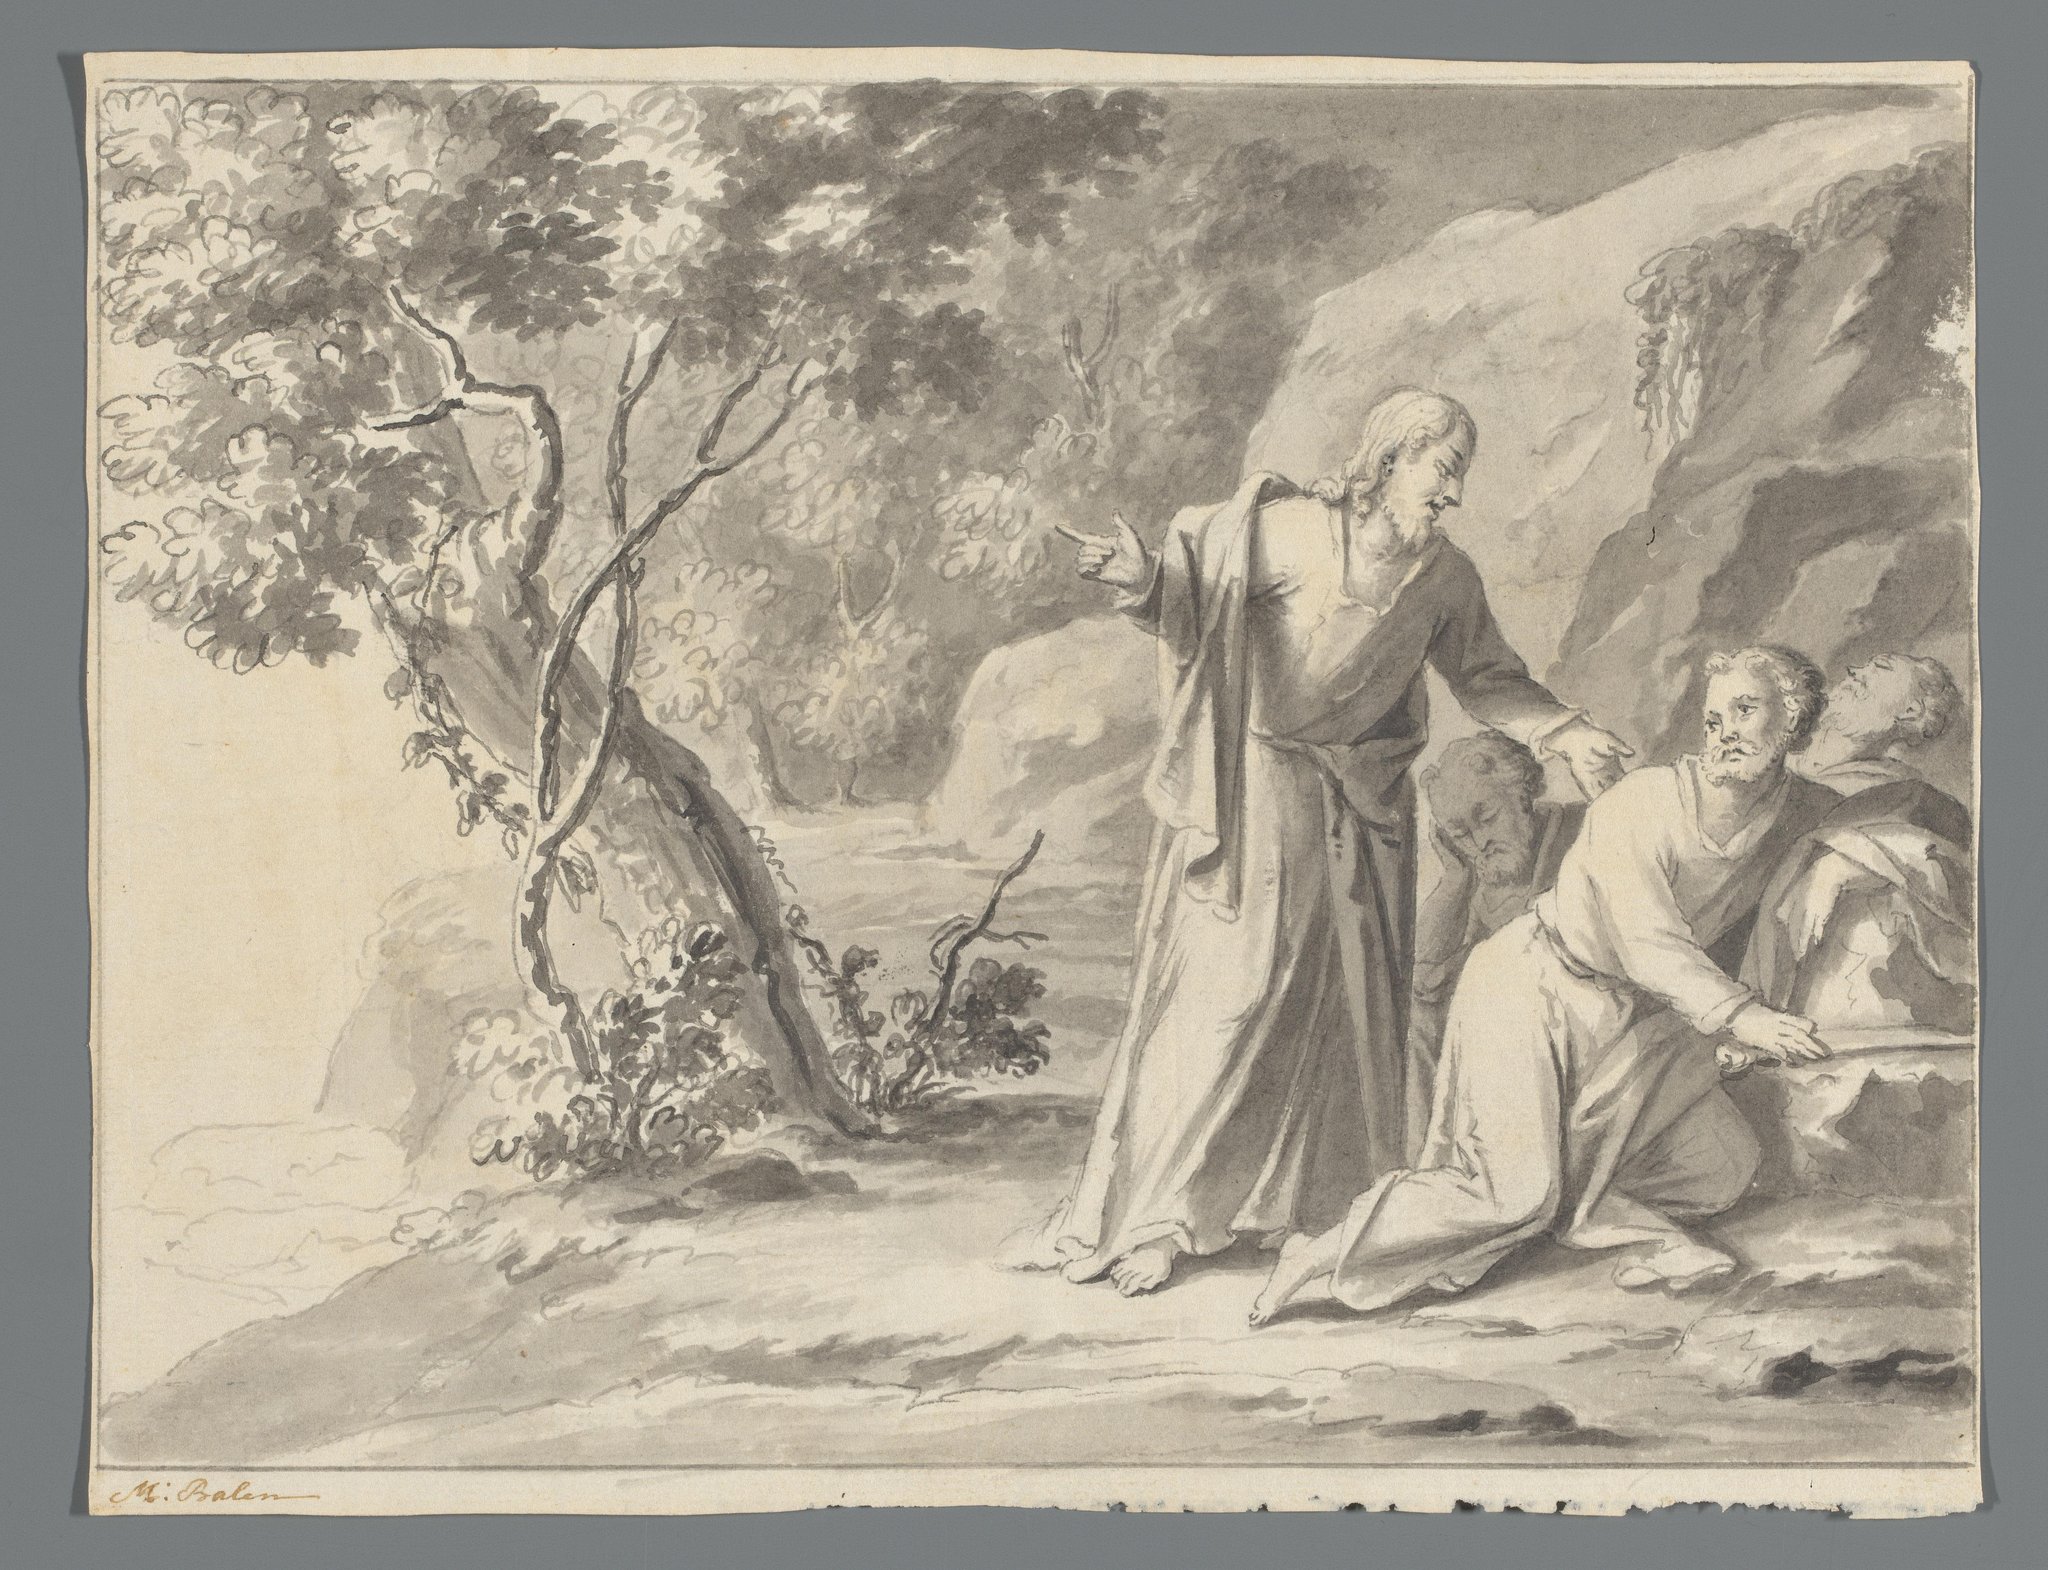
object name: drawing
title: Christus wekt de discipelen op de Olijfberg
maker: matthijs balen (1684-1766)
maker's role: draughtsman, painter, print maker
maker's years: 1684-1766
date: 1694-1766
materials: paper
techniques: brush, pen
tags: agony of christ; three (or eleven) apostles sleeping